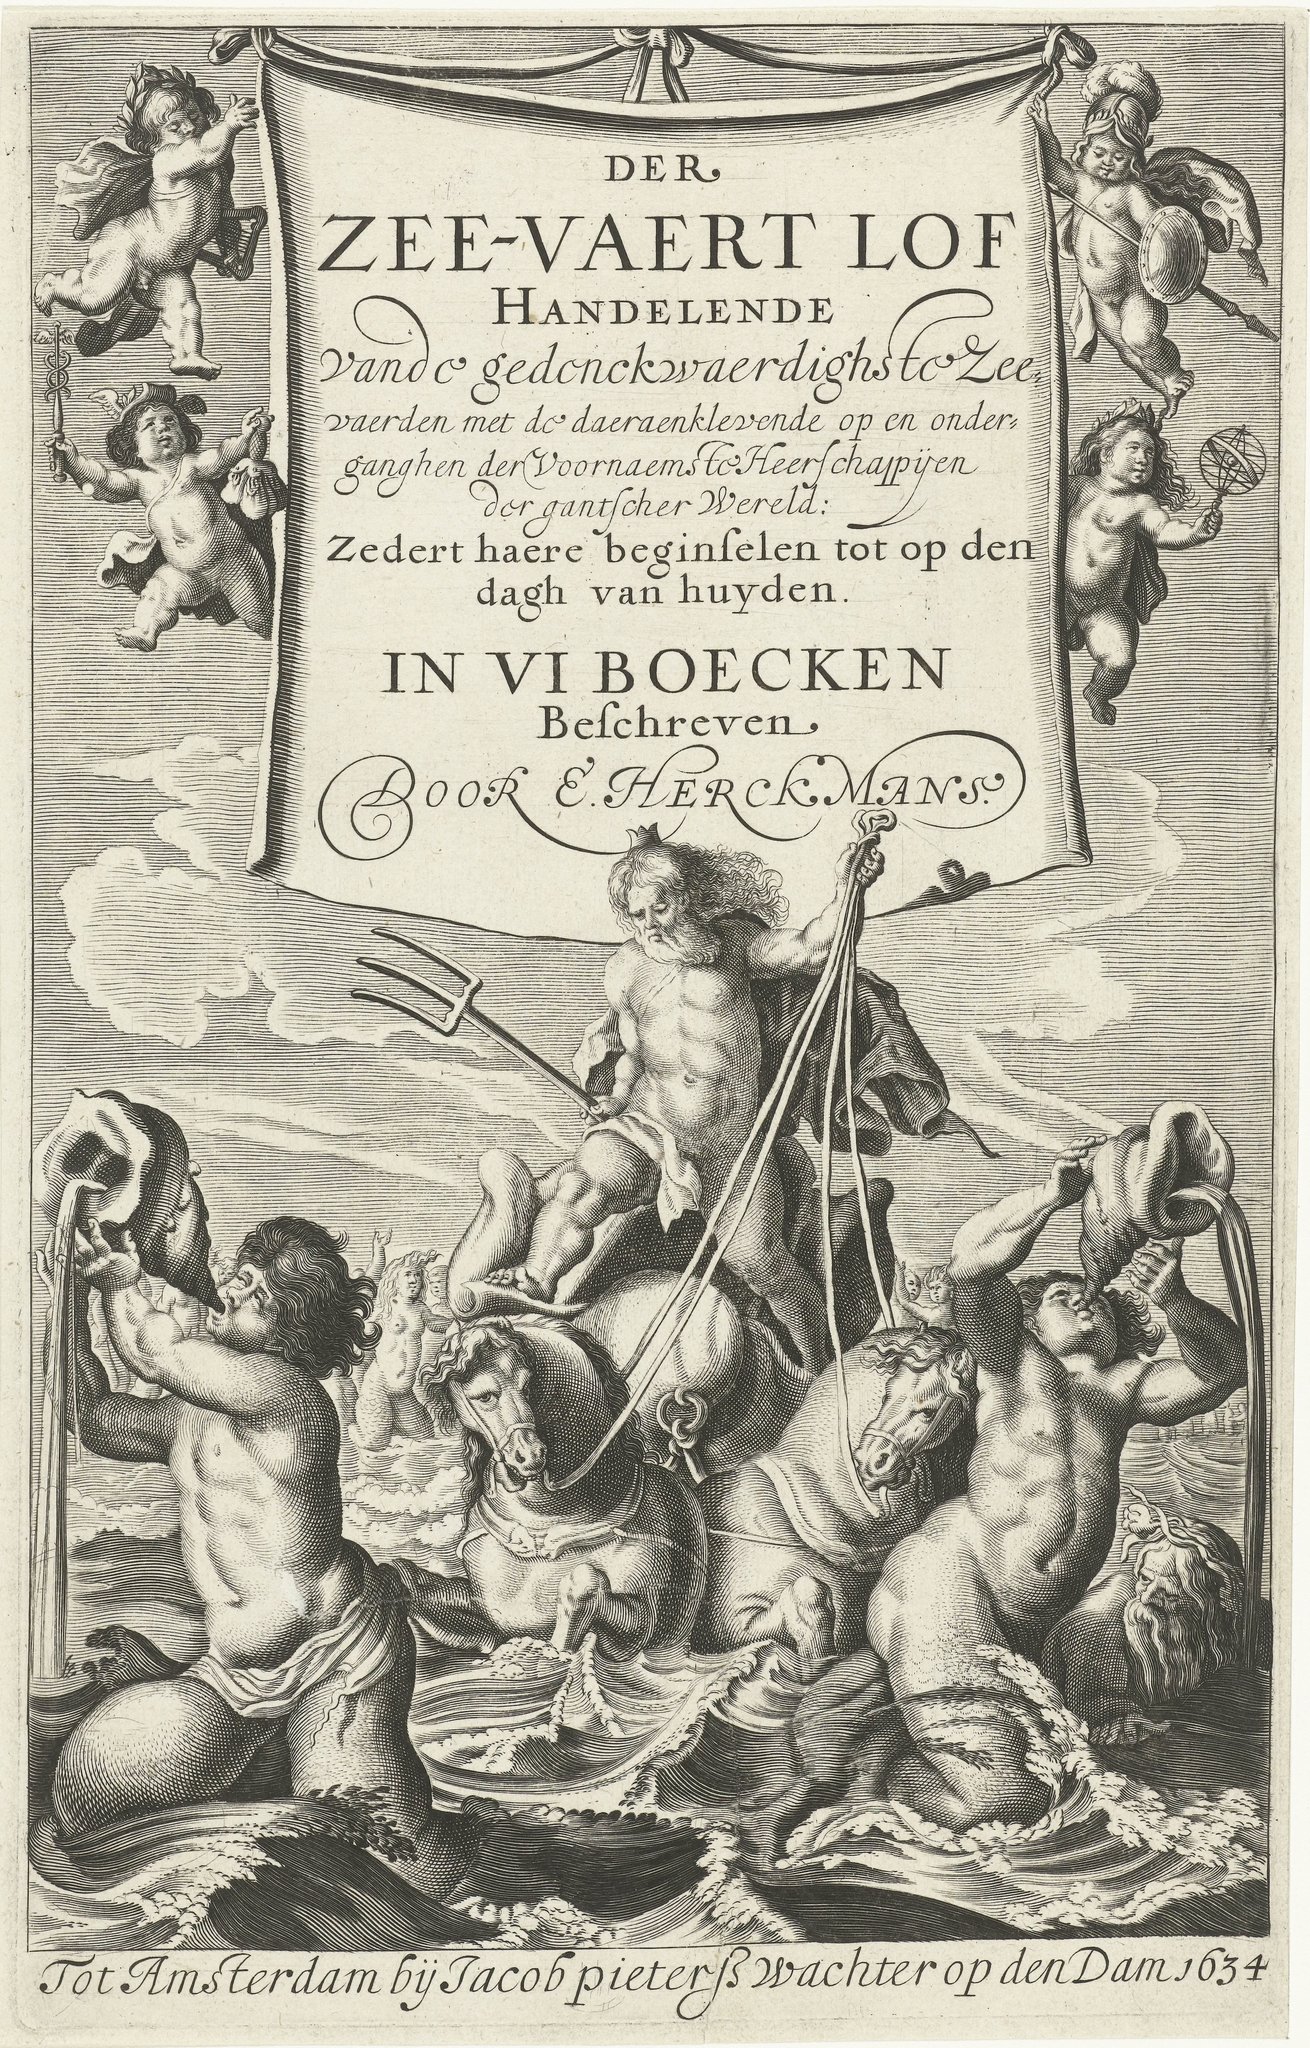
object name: print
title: Der zee-vaert lof handelende vande gedenckwaerdighste zeevaerden met de daeraenklevende op en onderganghen der voornaemste Heerschappijen der gantscher Wereld: Zedert haere beginselen tot op de dagh van huyden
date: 1634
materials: paper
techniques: engraving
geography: amsterdam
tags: (story of) neptune (poseidon)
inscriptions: collector's mark: Lugt 2228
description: Titelpagina voor: Elias Herckmans, Der zee-vaert lof handelende vande gedenckwaerdighste zeevaerden met de daeraenklevende op en onderganghen der voornaemste Heerschappijen der gantscher Wereld: Zedert haere beginselen tot op de dagh van huyden, Jacob Pietersz. Wachter, Amsterdam 1634